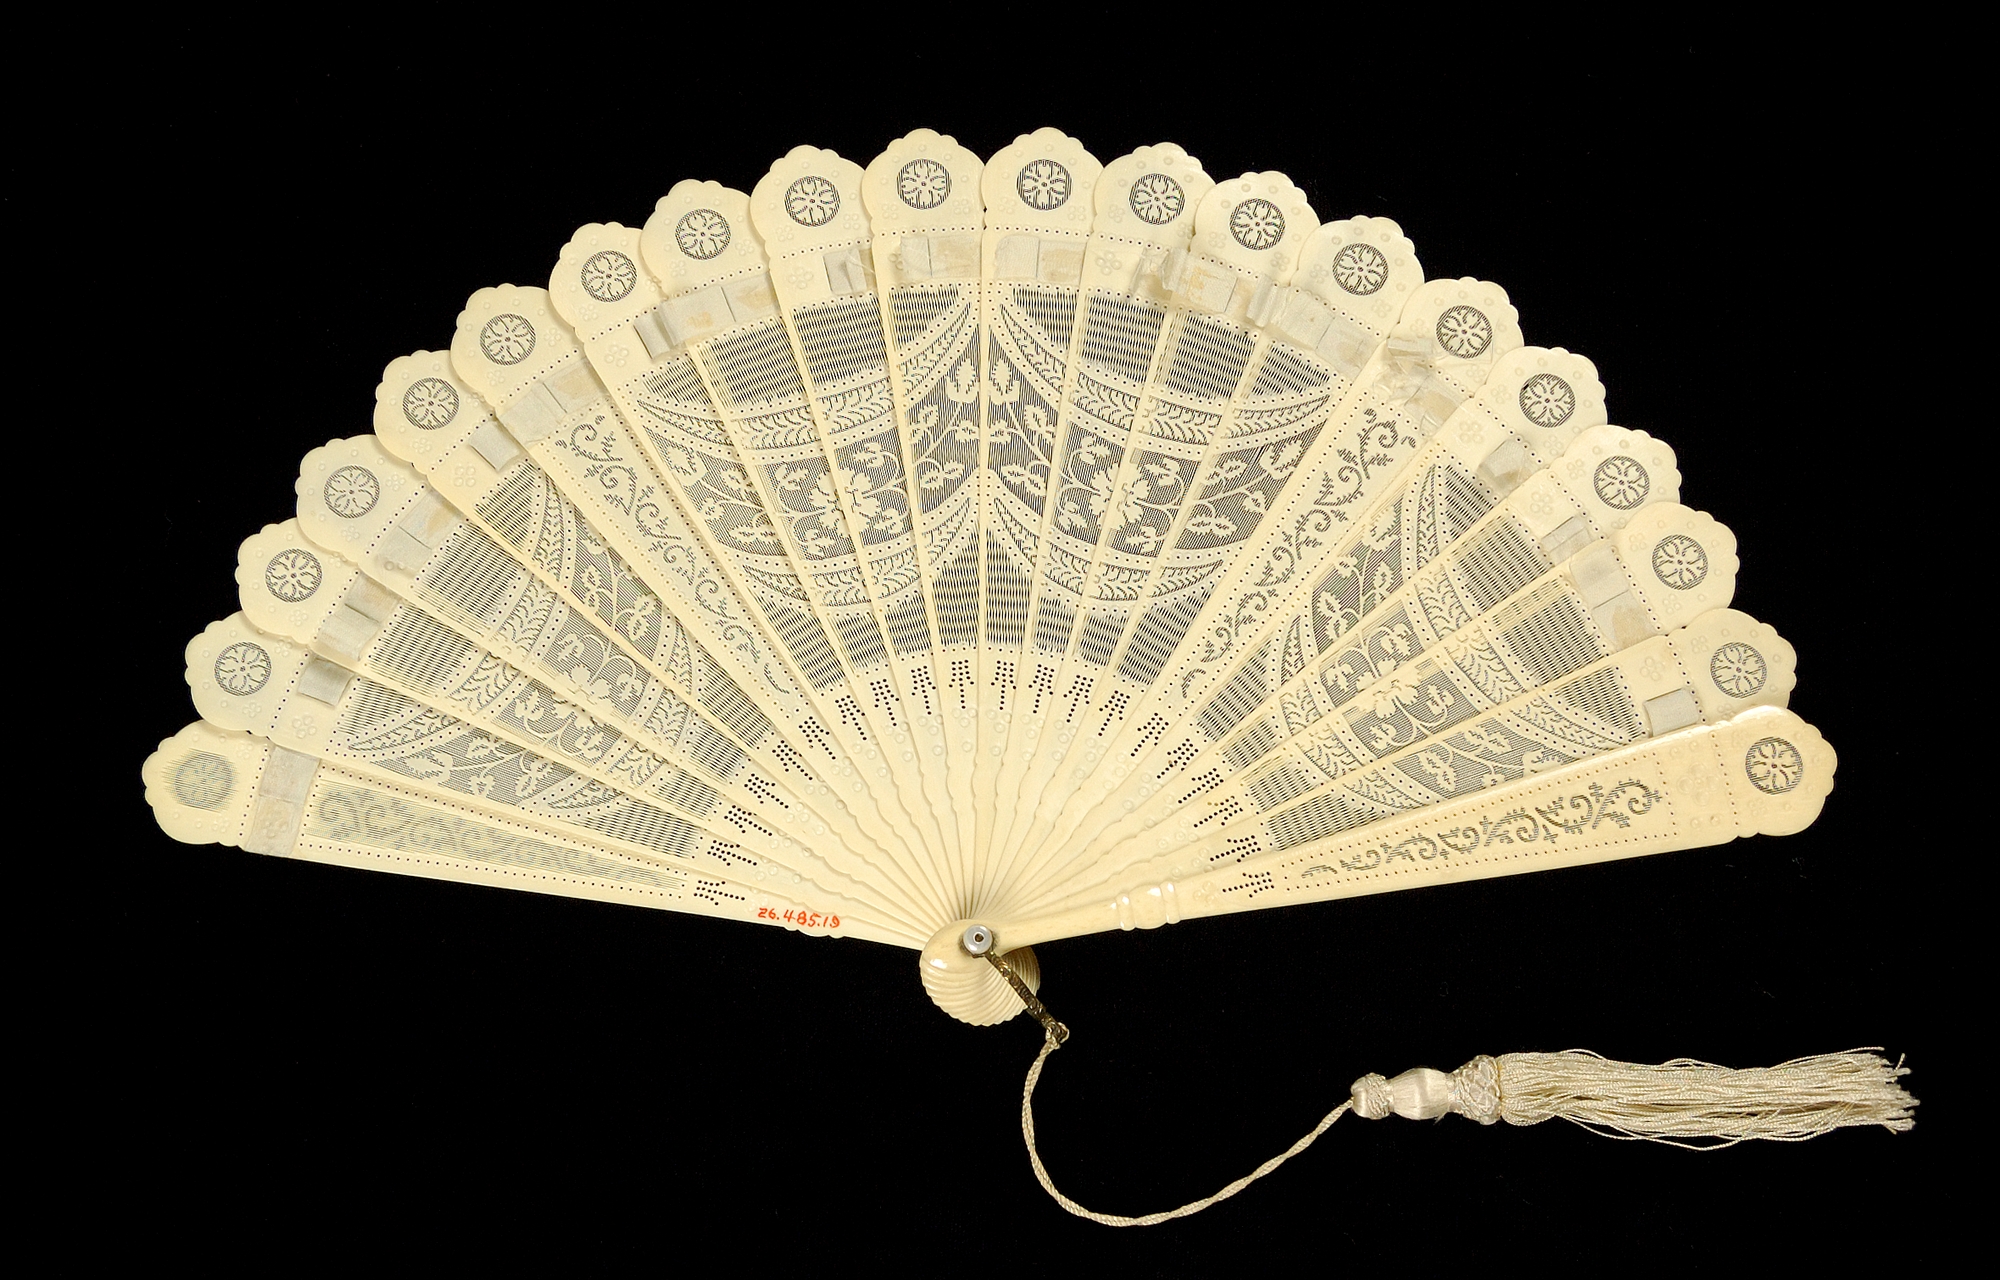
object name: brisé fan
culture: chinese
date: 1870-1890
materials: bone, metal, mother of pearl, silk